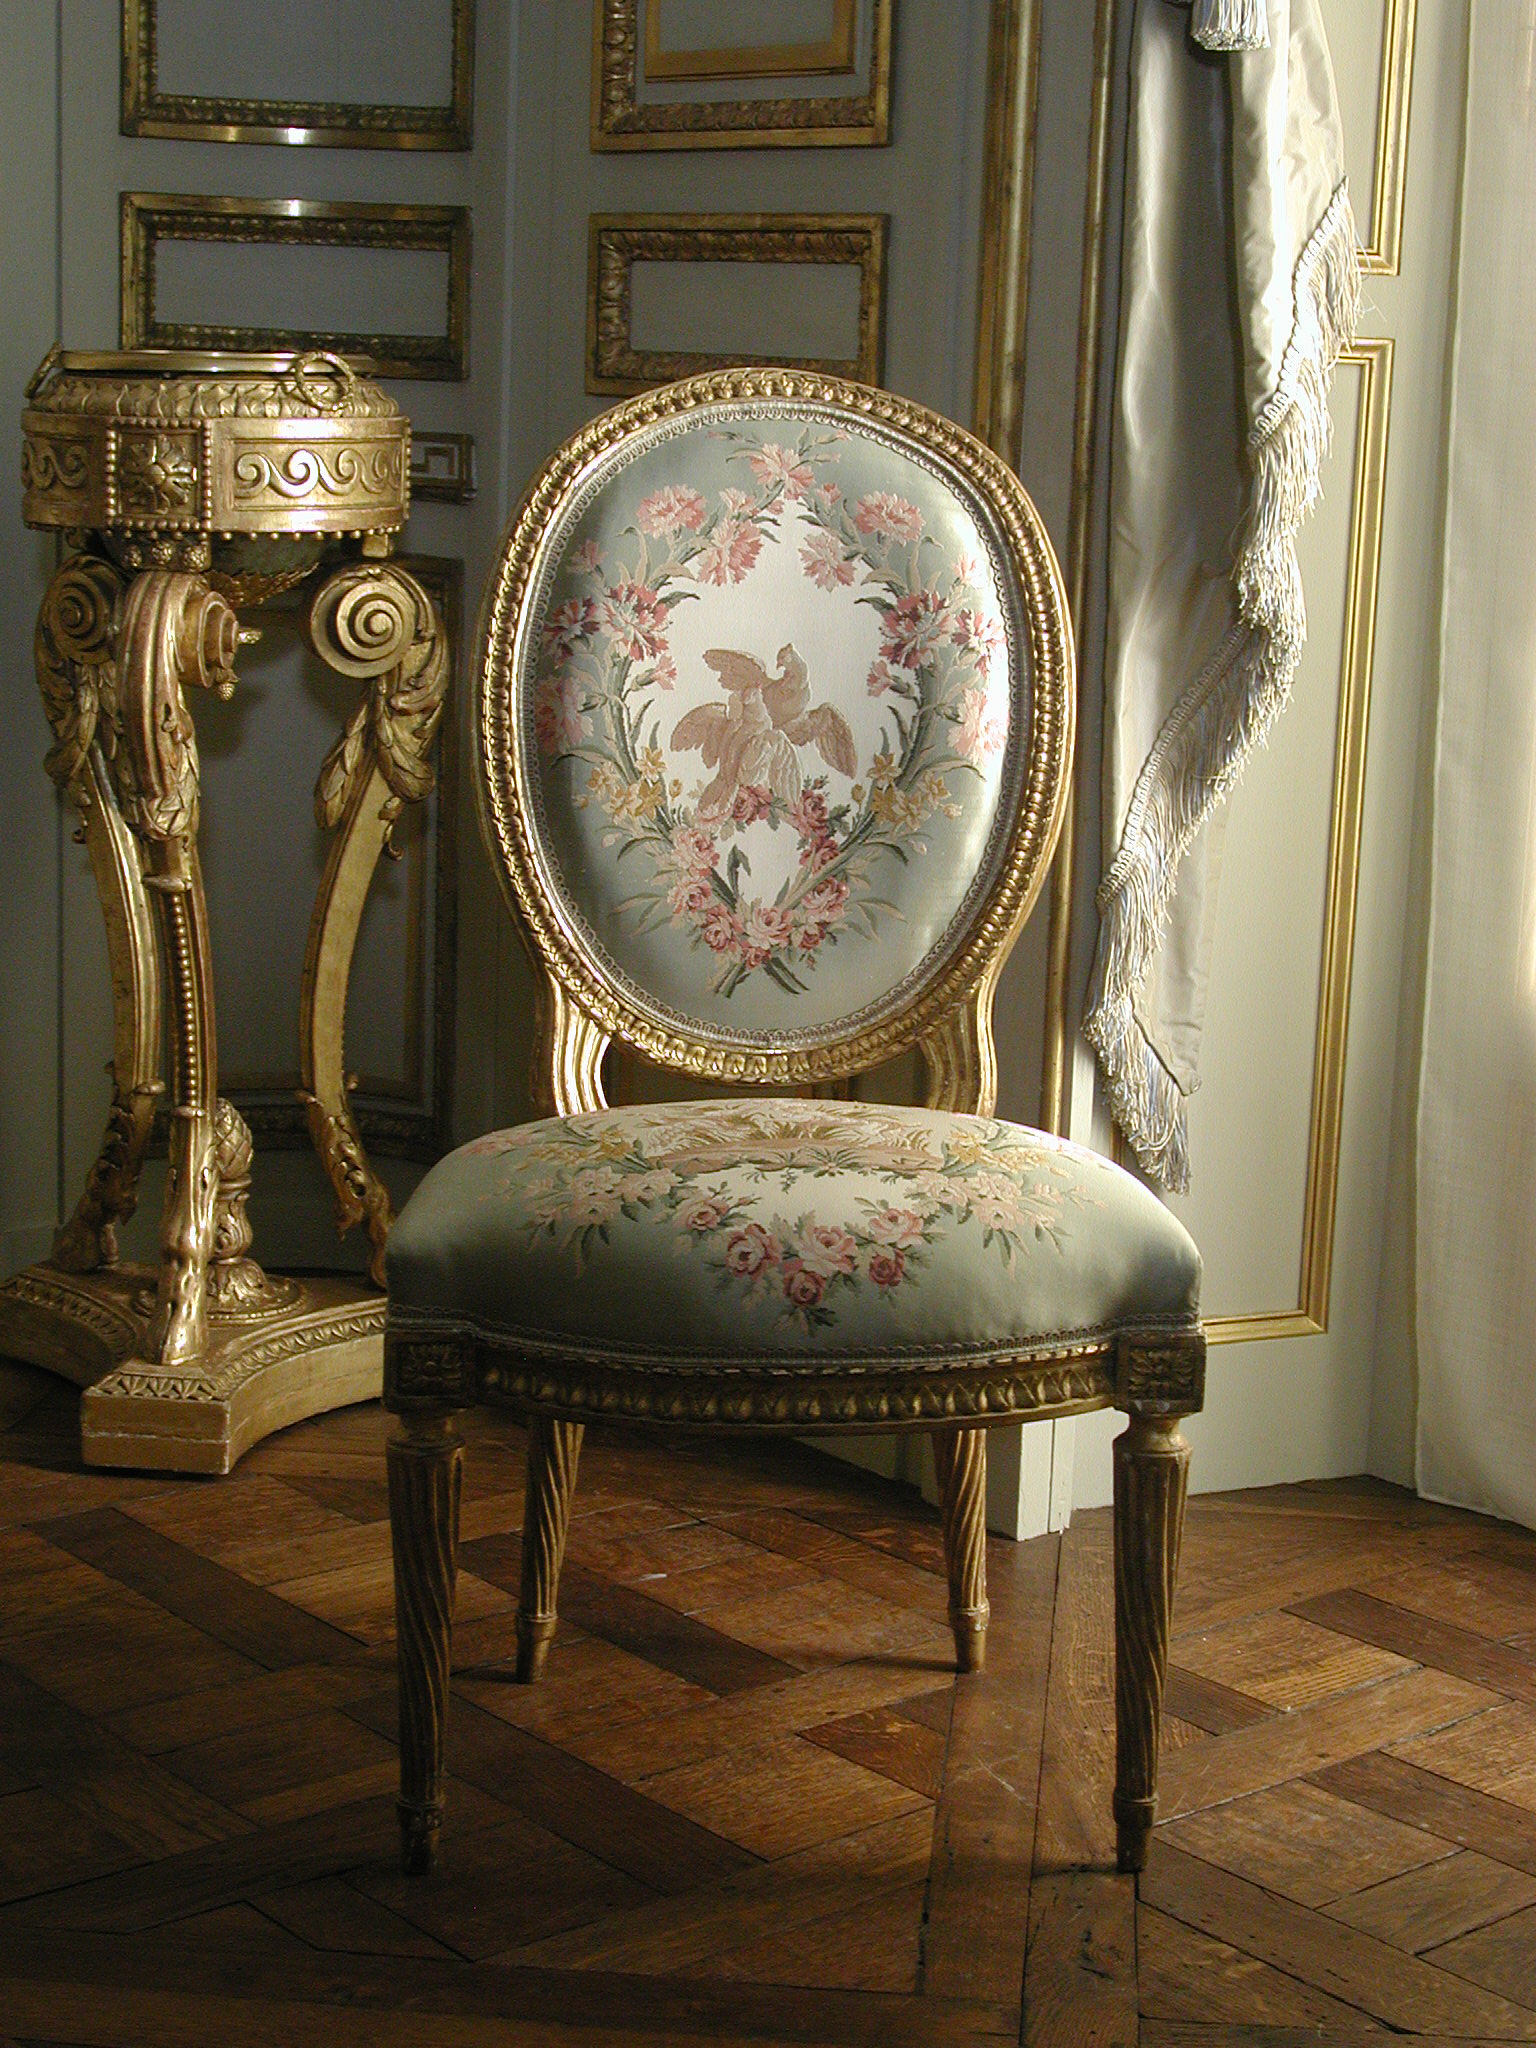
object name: side chair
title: Side chair (one of a pair)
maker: jean-jacques pothier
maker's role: maker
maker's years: 1750-1780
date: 1775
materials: wood, silk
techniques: carving, gilding, moire